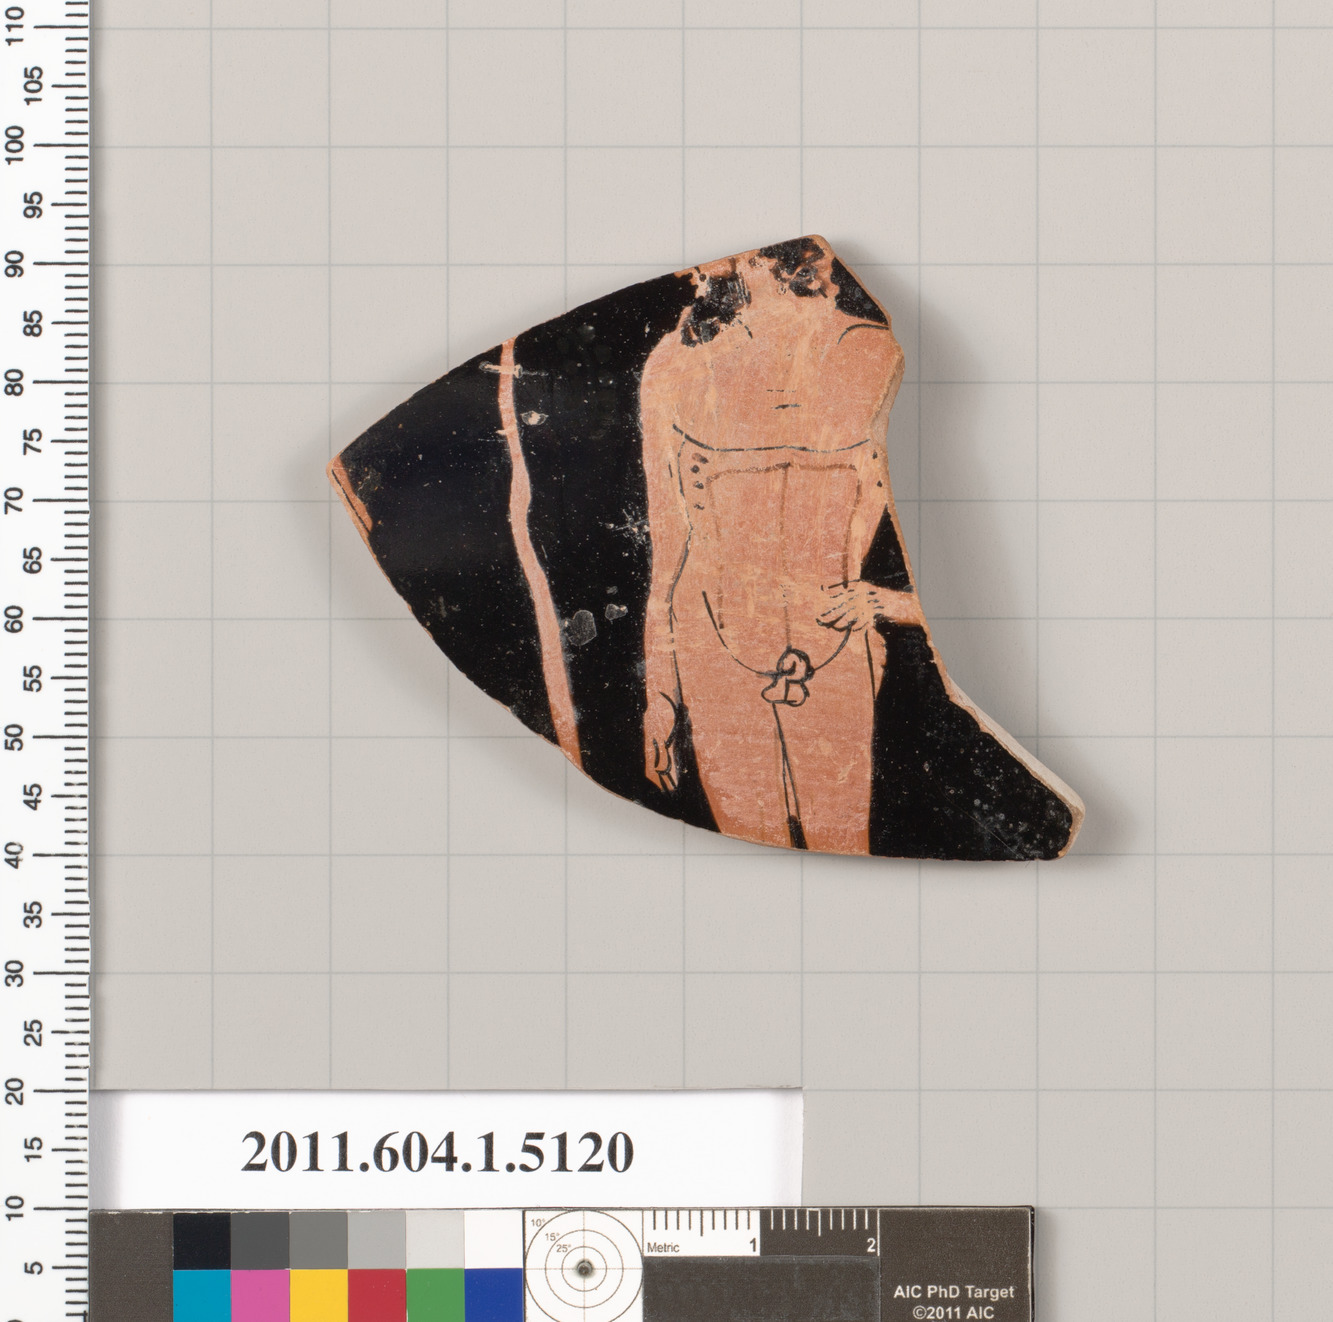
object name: kylix fragment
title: Terracotta fragment of a kylix (drinking cup)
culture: greek, attic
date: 475-451 BCE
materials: terracotta